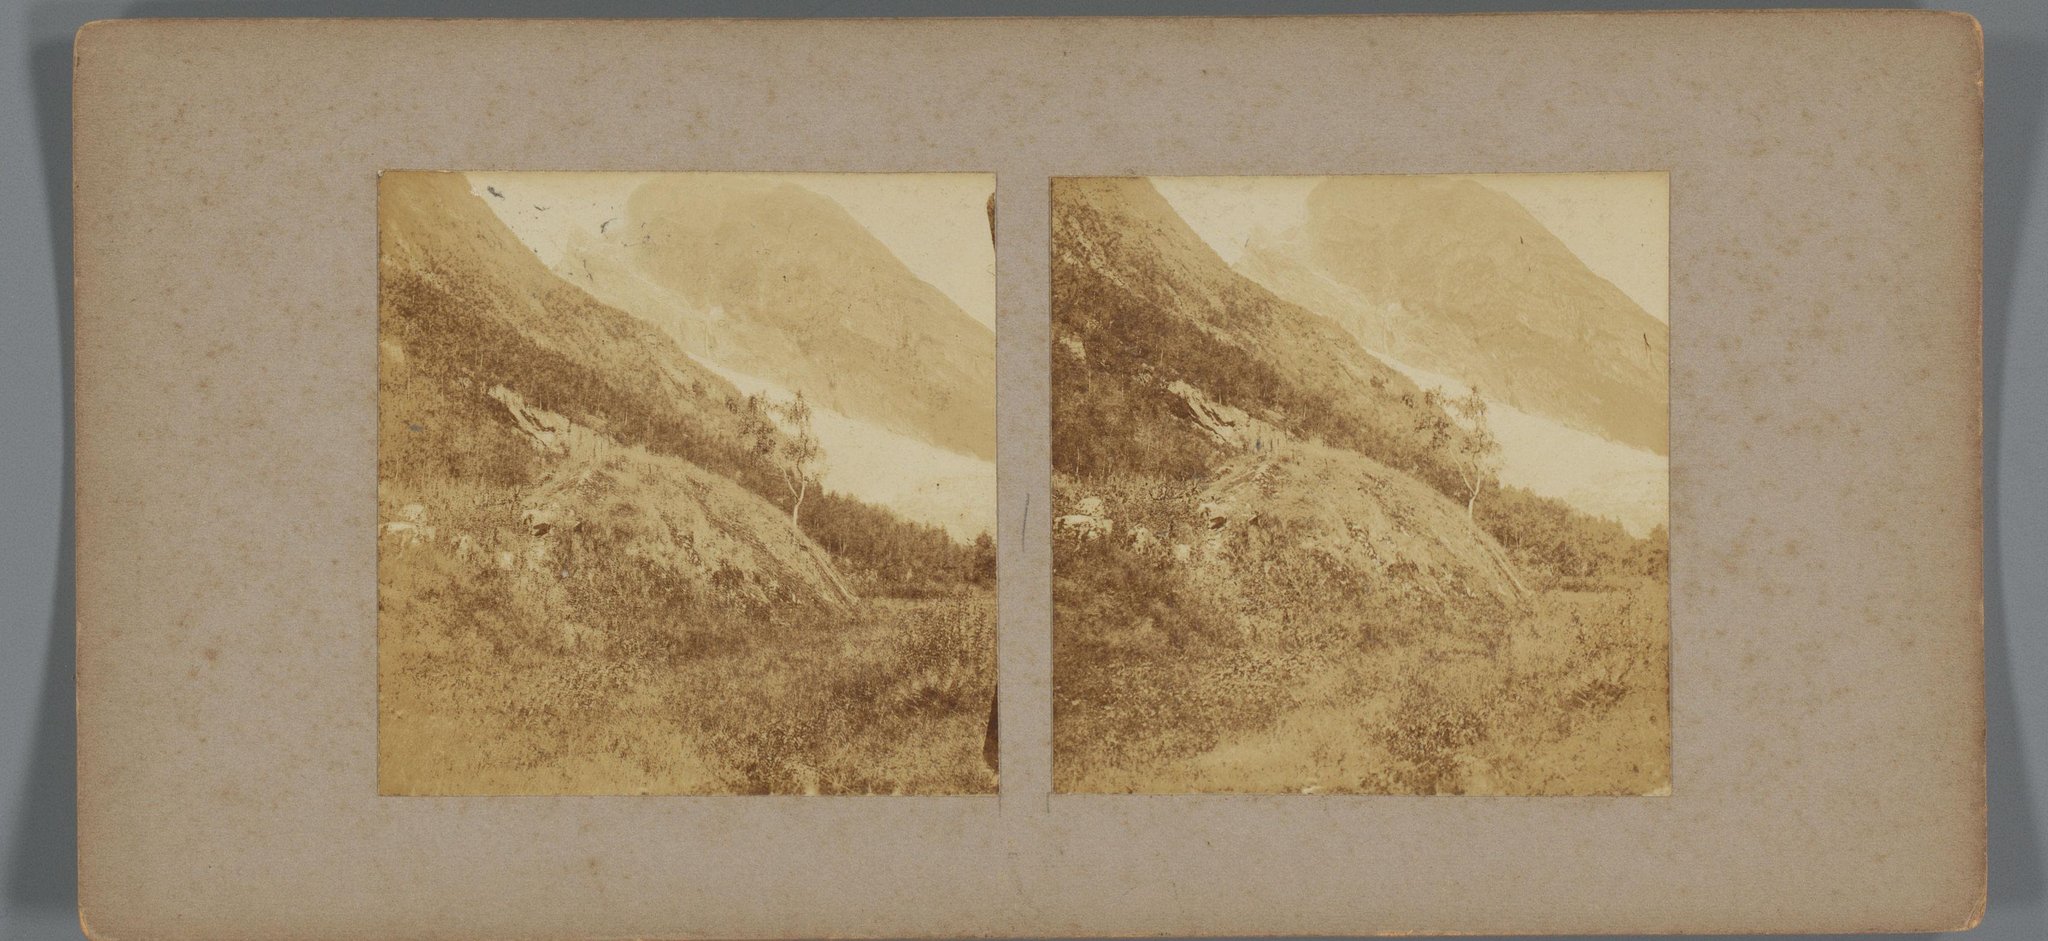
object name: stereograph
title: Supphellebreengletsjer in het Sogndal in Noorwegen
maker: Anonymous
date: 1882-1890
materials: cardboard, photographic support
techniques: gelatin silver print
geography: jostedalsbreen national park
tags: glacier